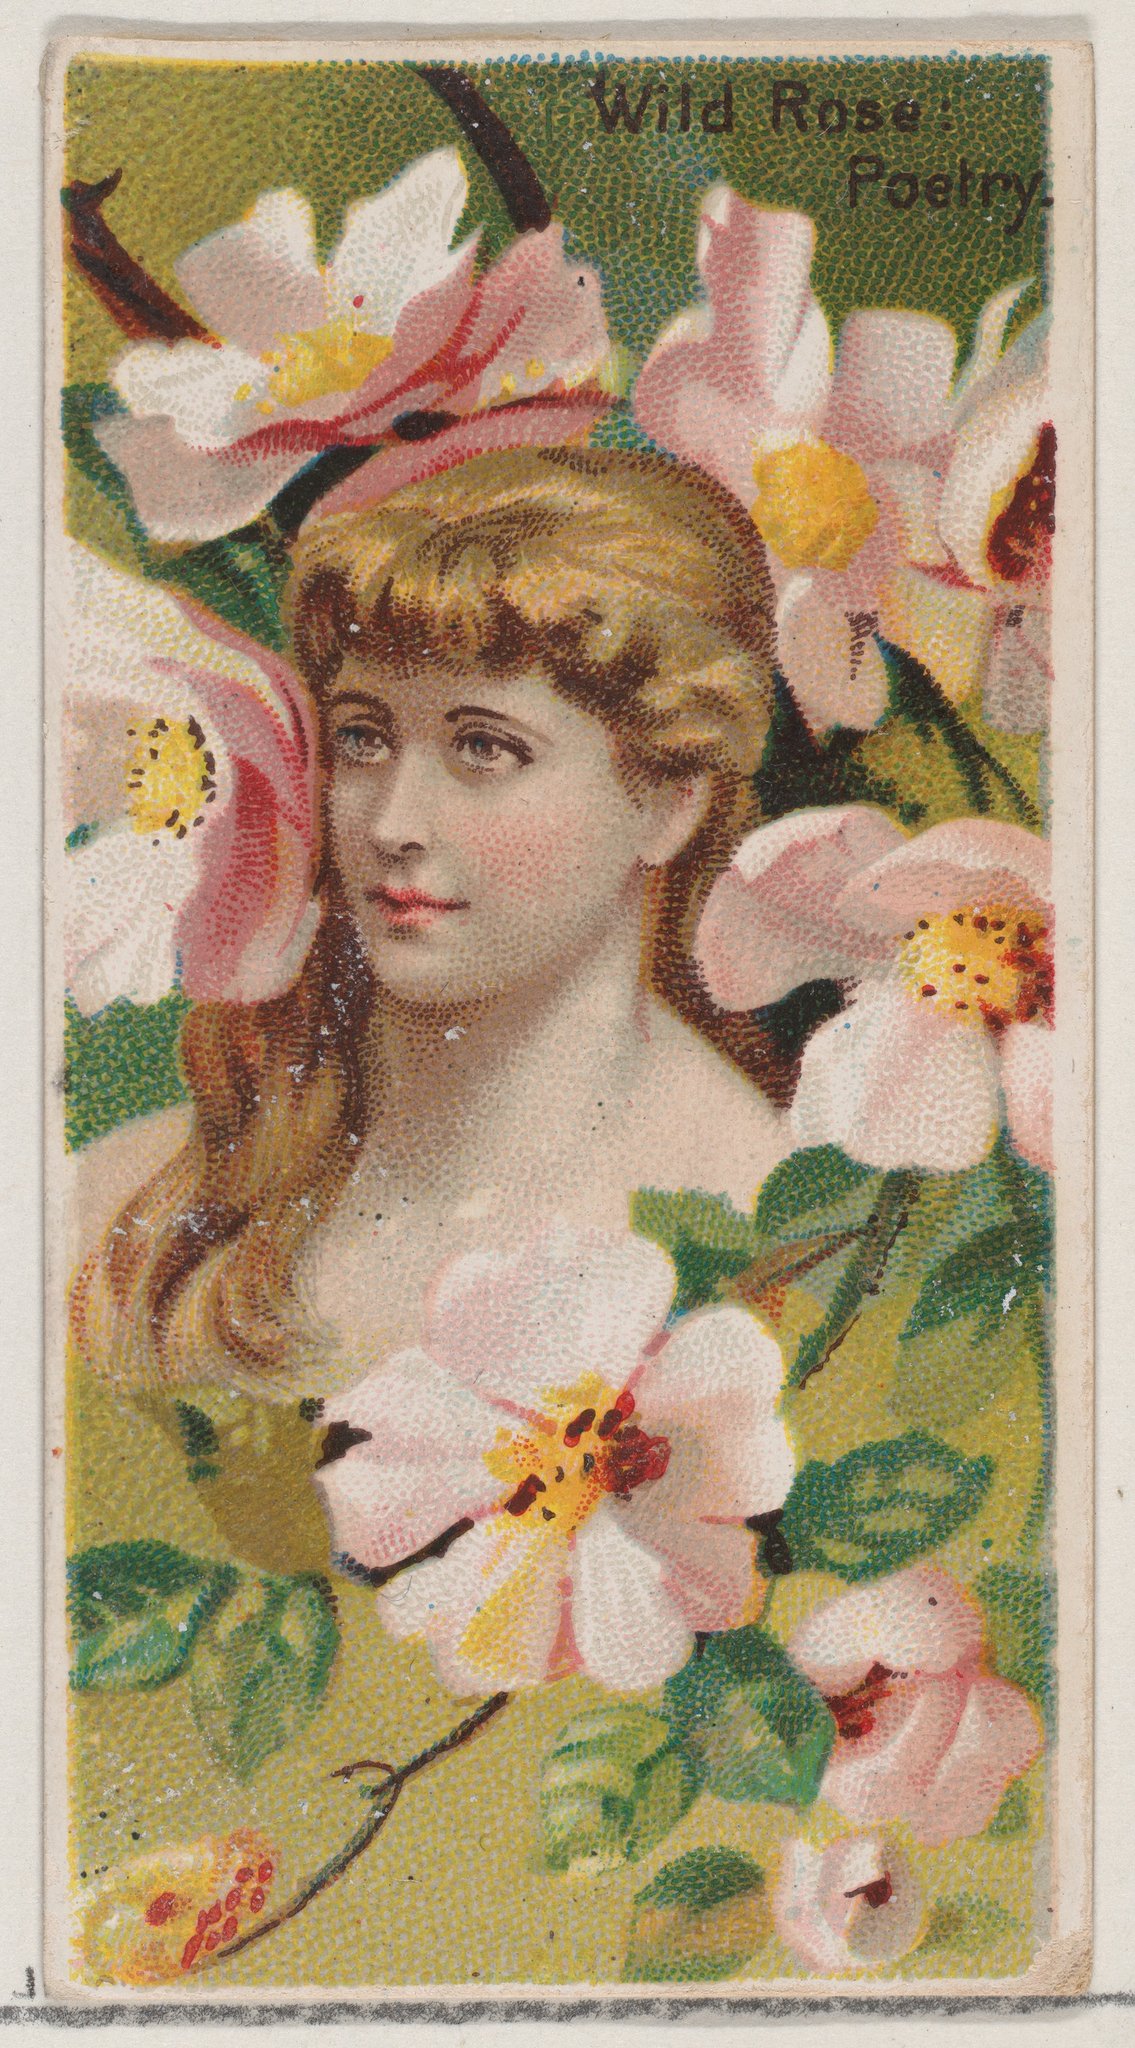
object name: print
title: Wild Rose: Poetry, from the series Floral Beauties and Language of Flowers (N75) for Duke brand cigarettes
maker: american tobacco company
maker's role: publisher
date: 1892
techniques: color lithograph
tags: women,flowers